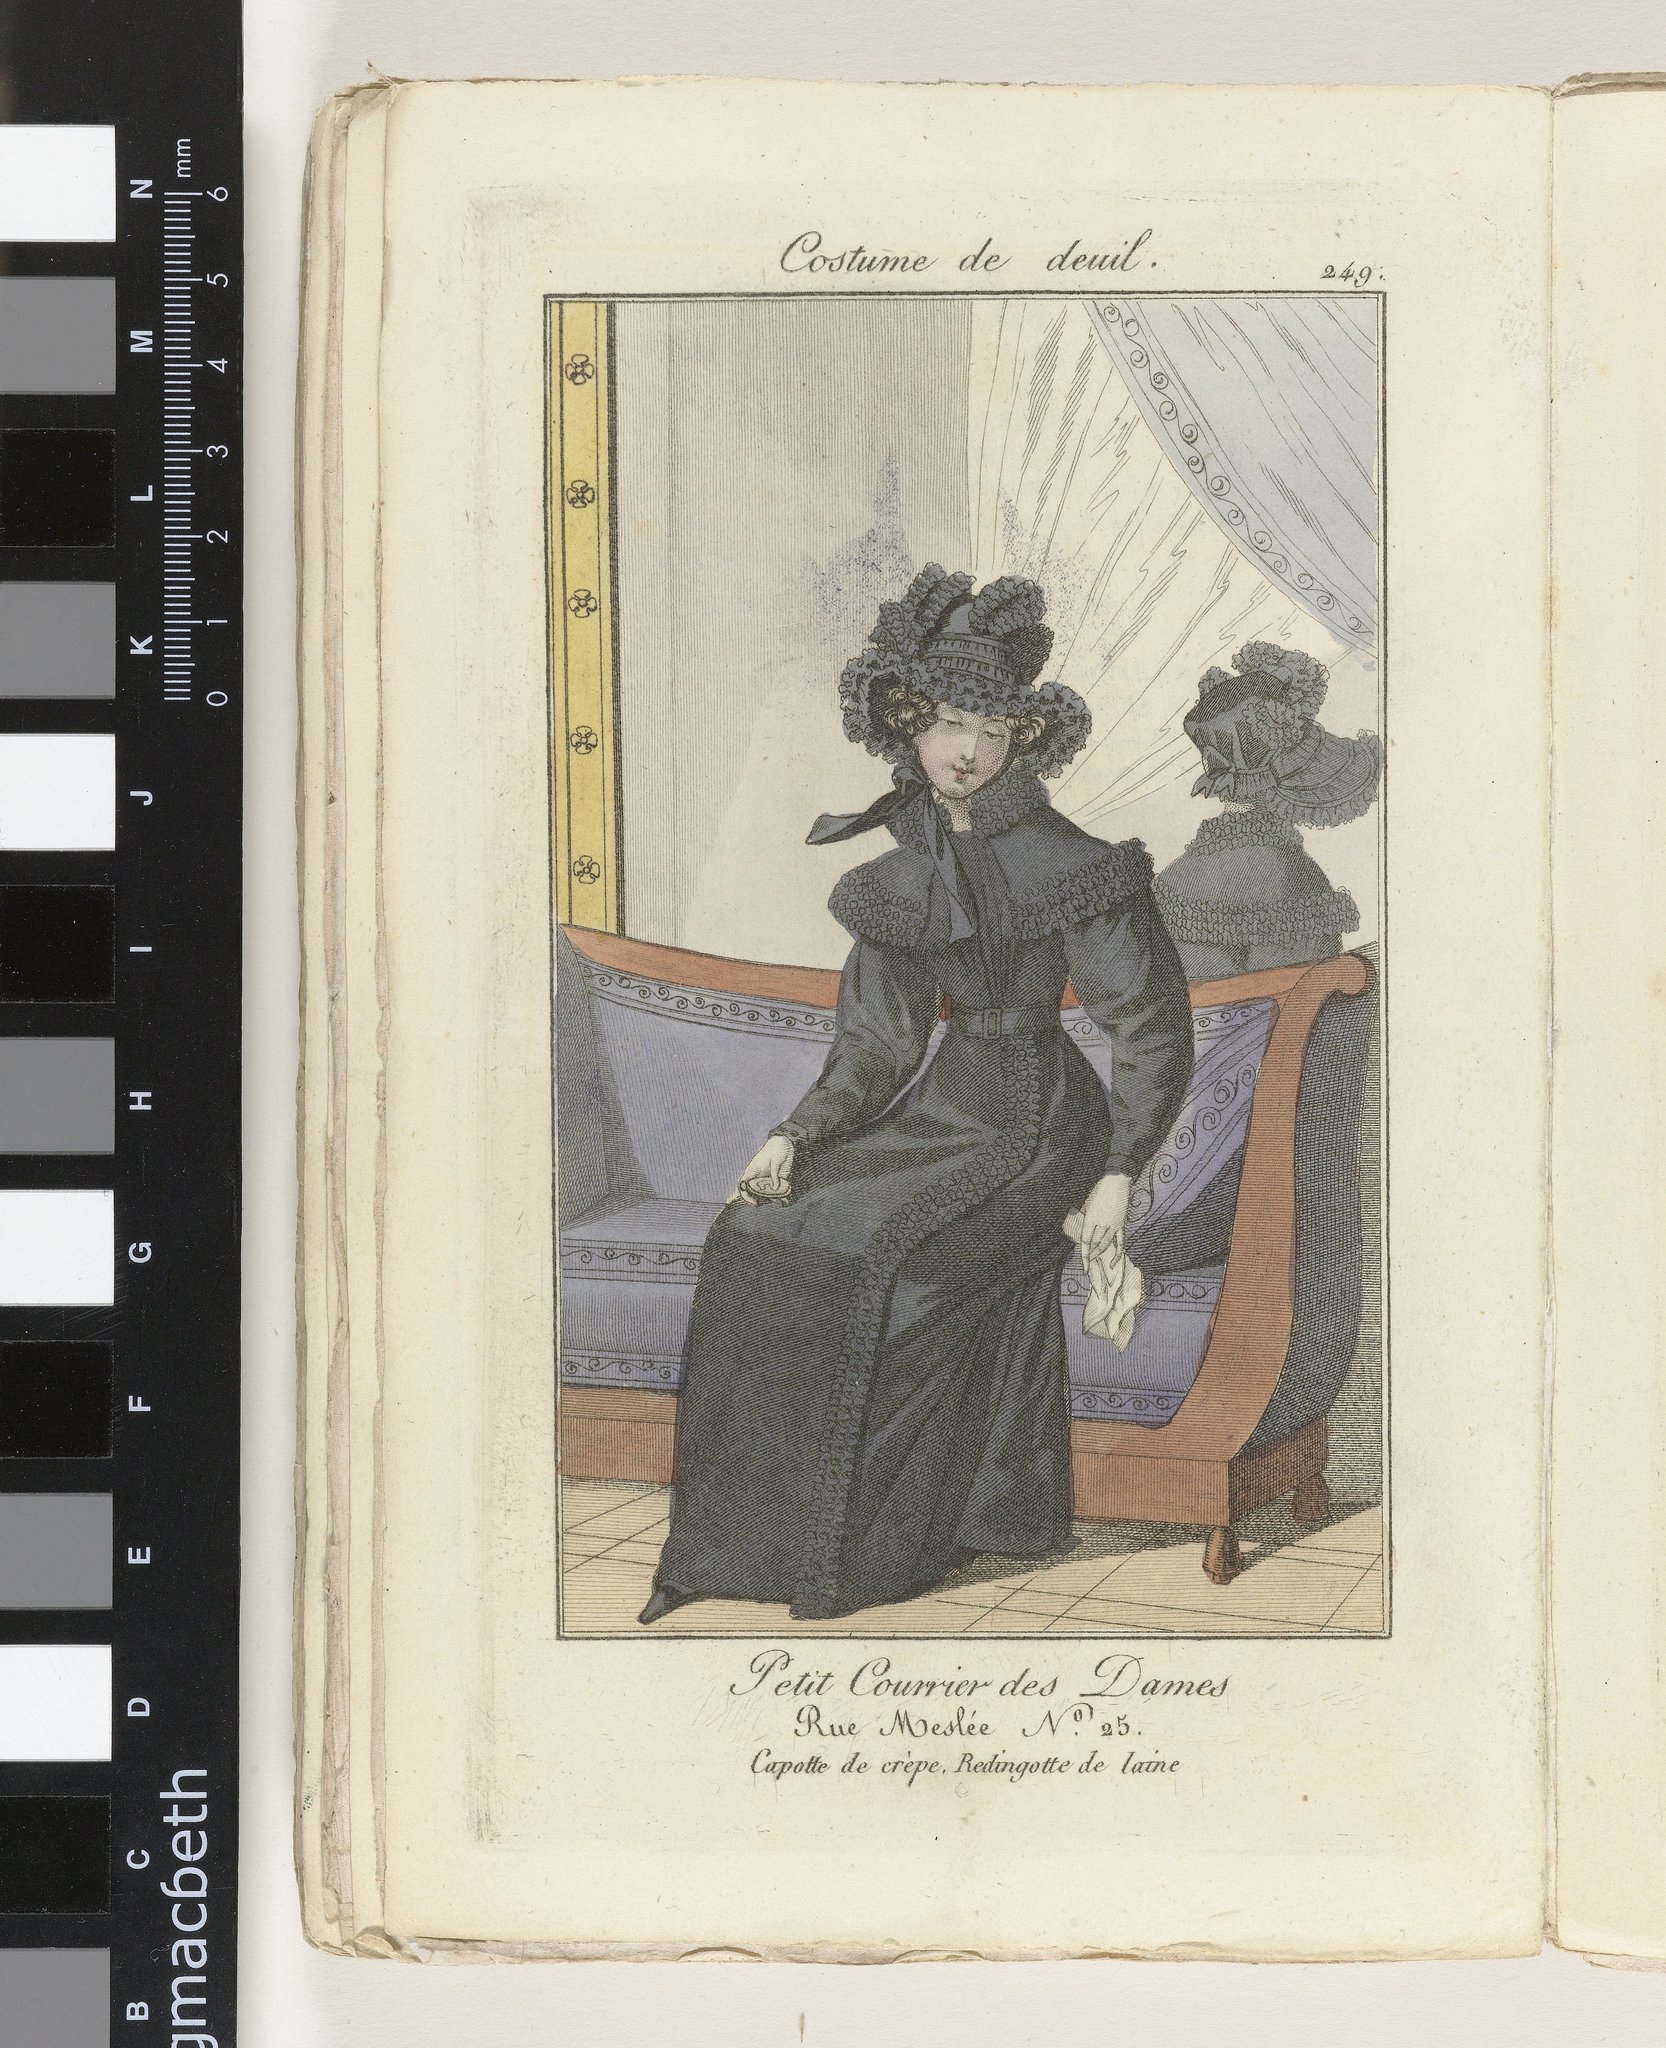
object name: magazine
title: Costume de deuil 1824 (249)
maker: Anonymous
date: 1824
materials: paper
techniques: engraving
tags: fashion plates